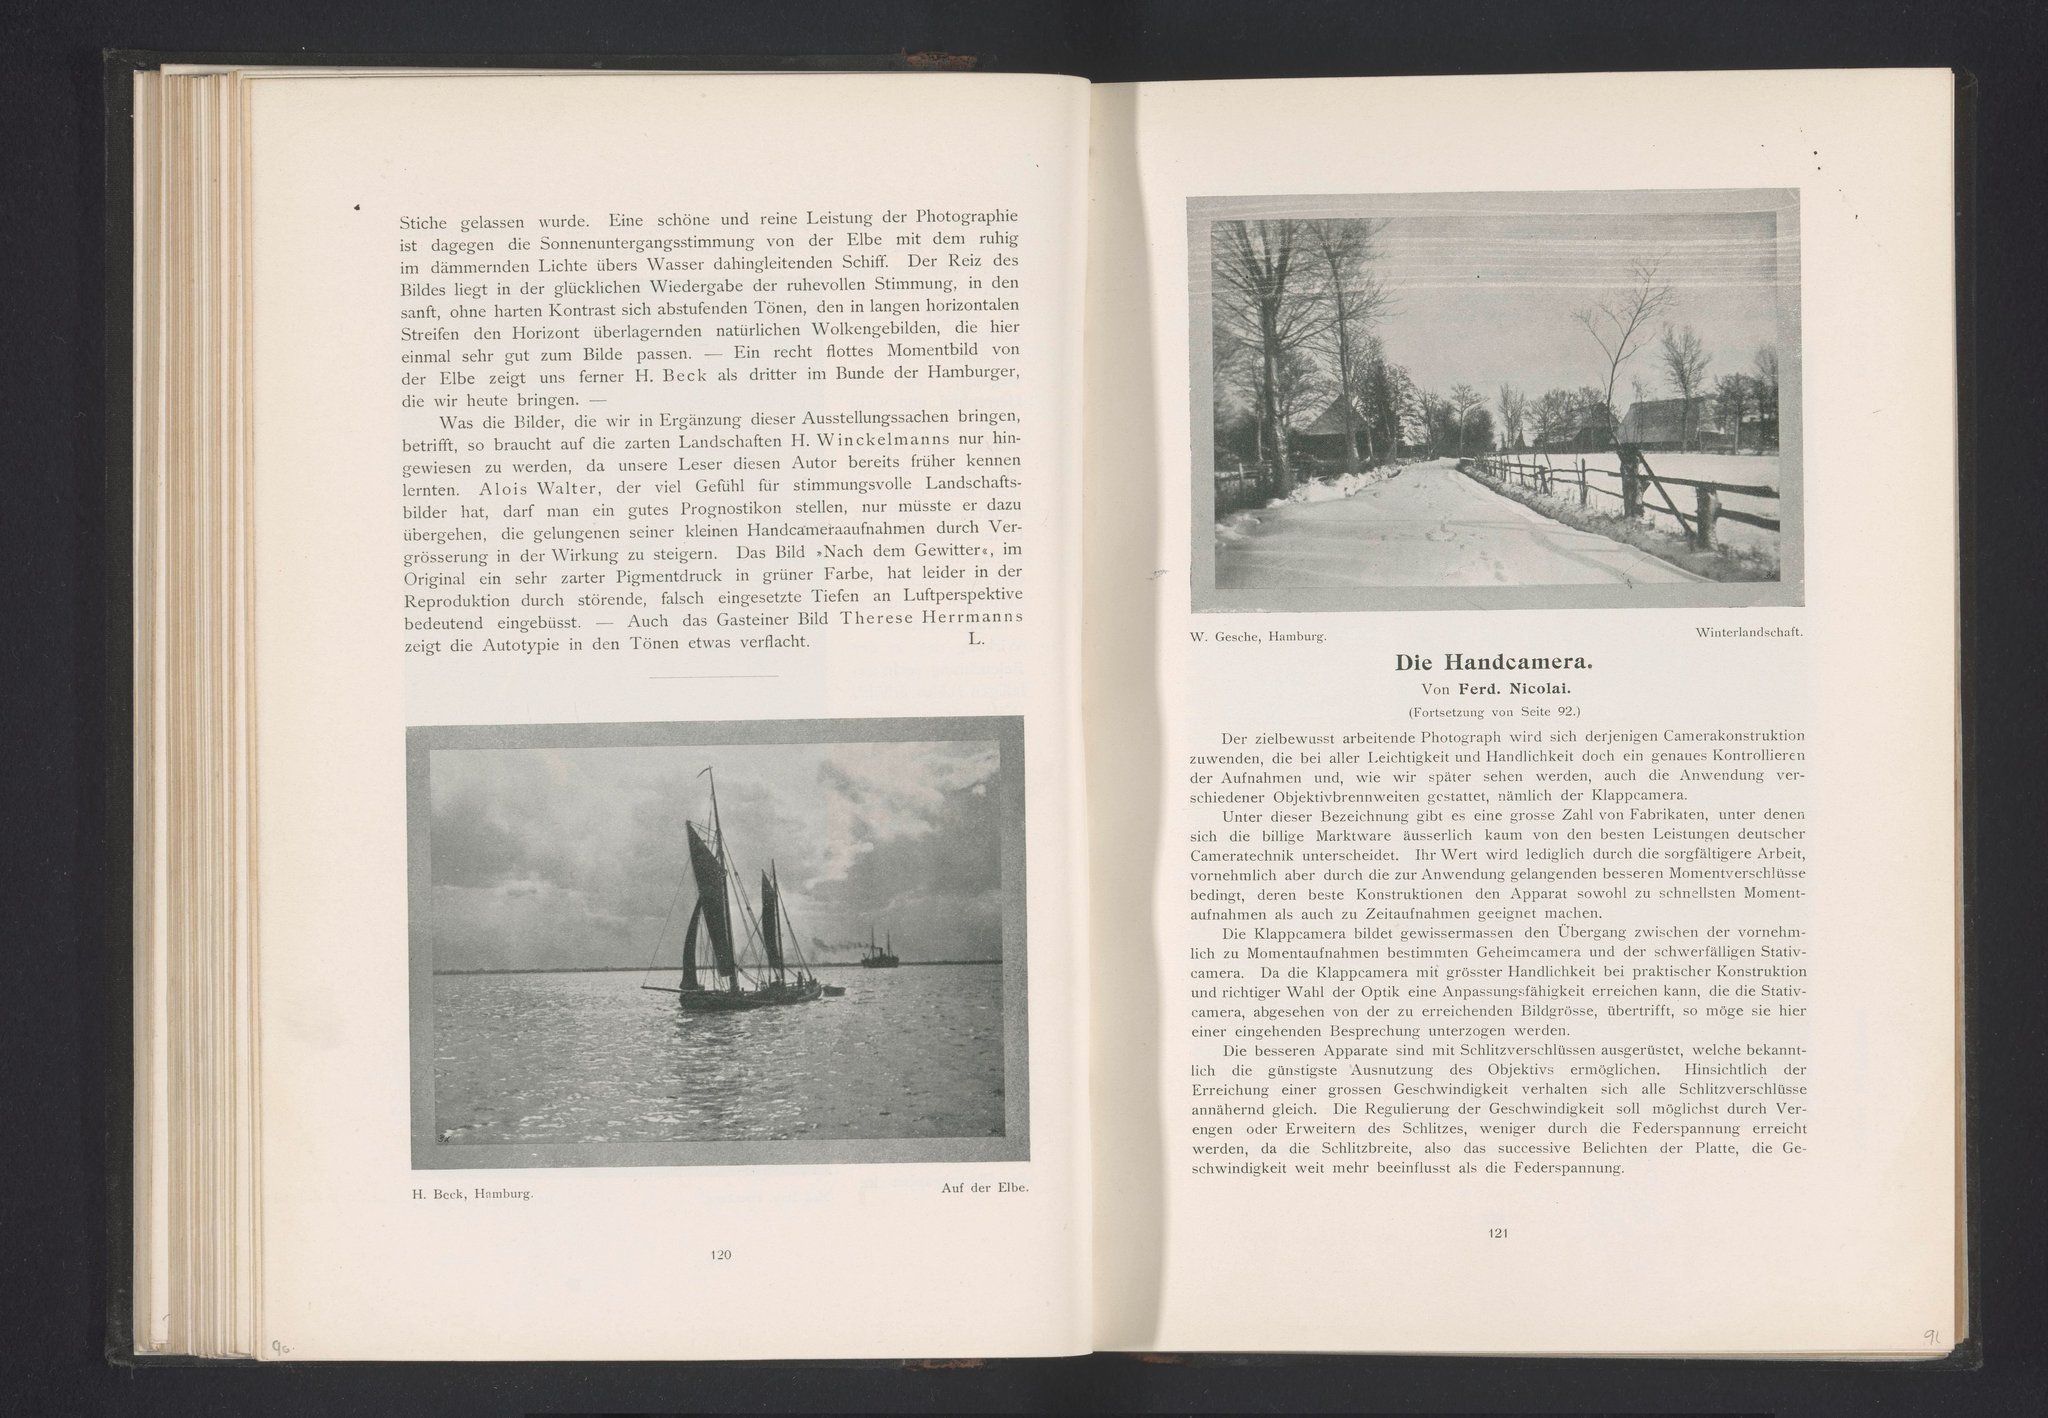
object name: photomechanical print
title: Auf der Elbe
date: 1898-1903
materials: paper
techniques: autotype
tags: sailing-ship, sailing-boat, river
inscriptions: inscription: ‘Hamburg’, monogram: ‘BX’